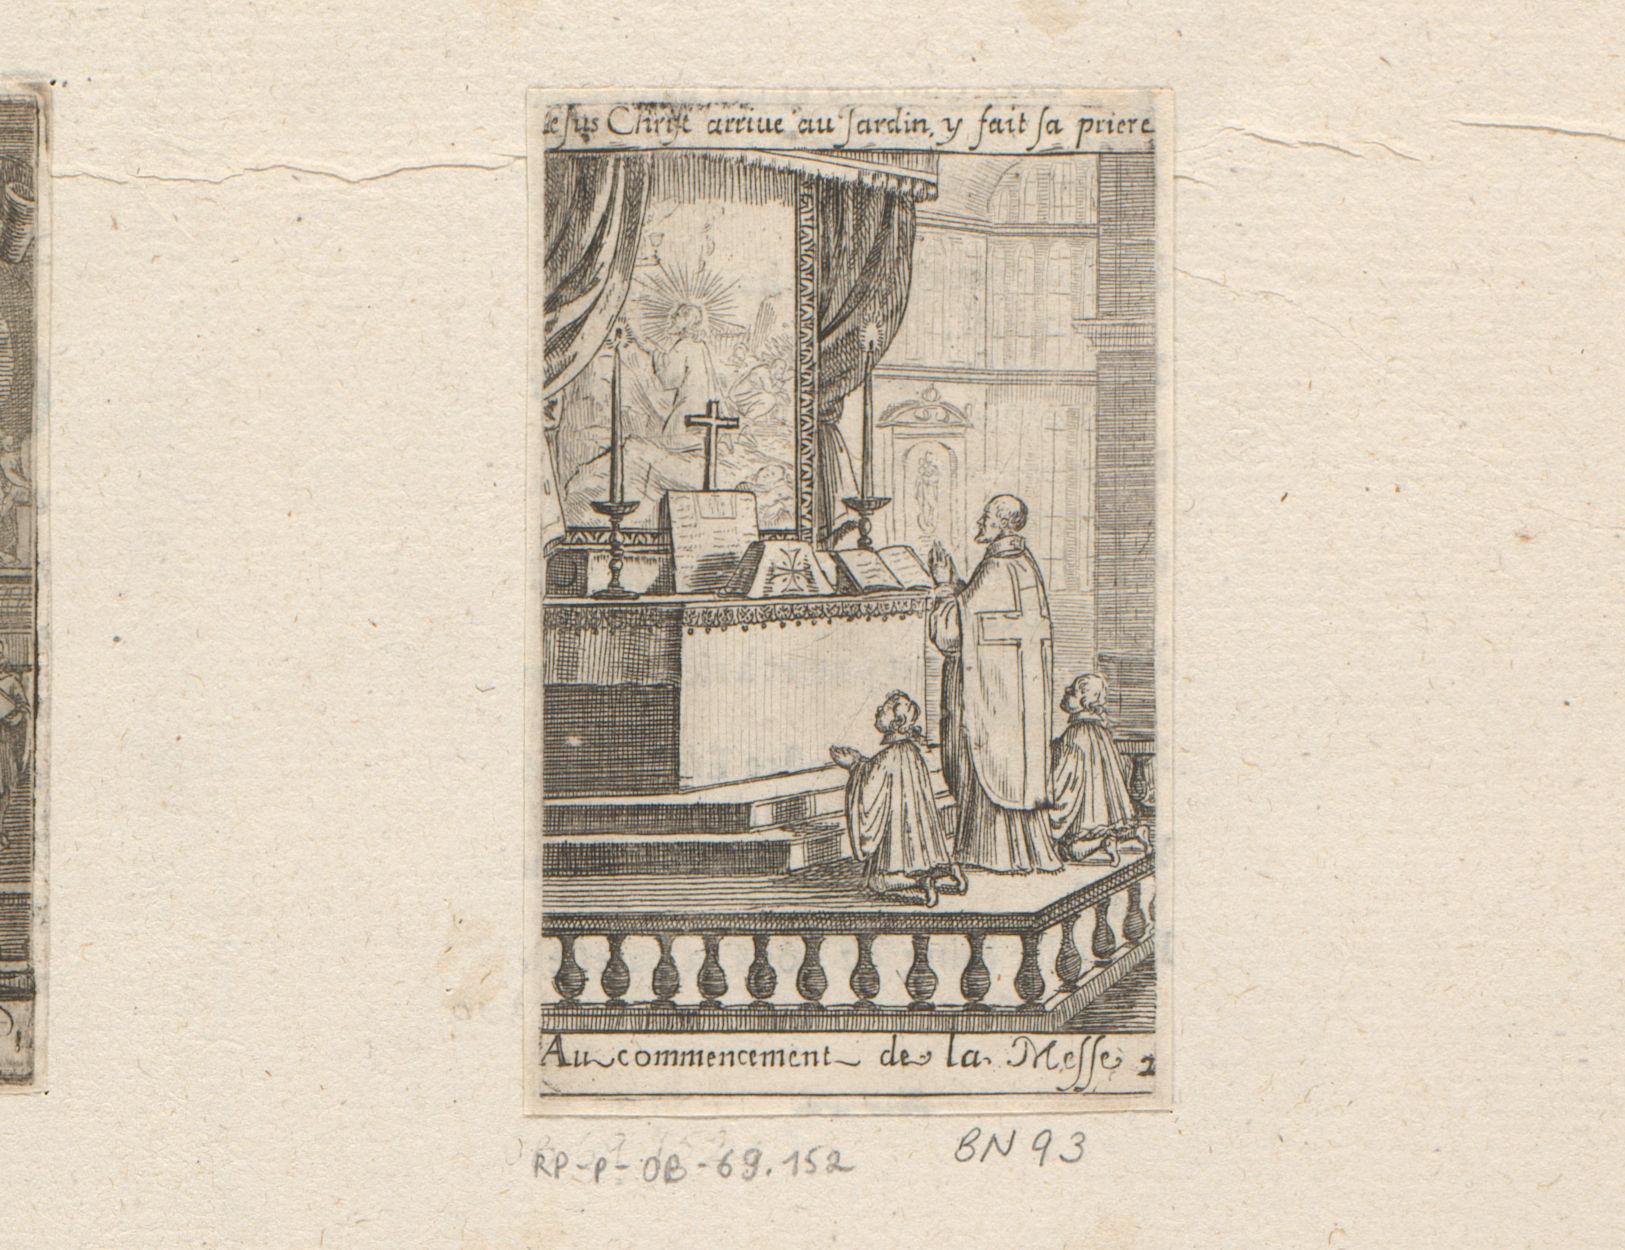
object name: print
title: Au commencement de la Messe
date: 1661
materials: paper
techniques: etching, letterpress printing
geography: france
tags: priest (roman catholic), altar with altar-piece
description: Prent uit: Mengin, L. Tableaux ou sont representees la passion de N.S. Christ et les actions du prestre a la S. Messe (...). Metz: Claude Bouchard, 1661.